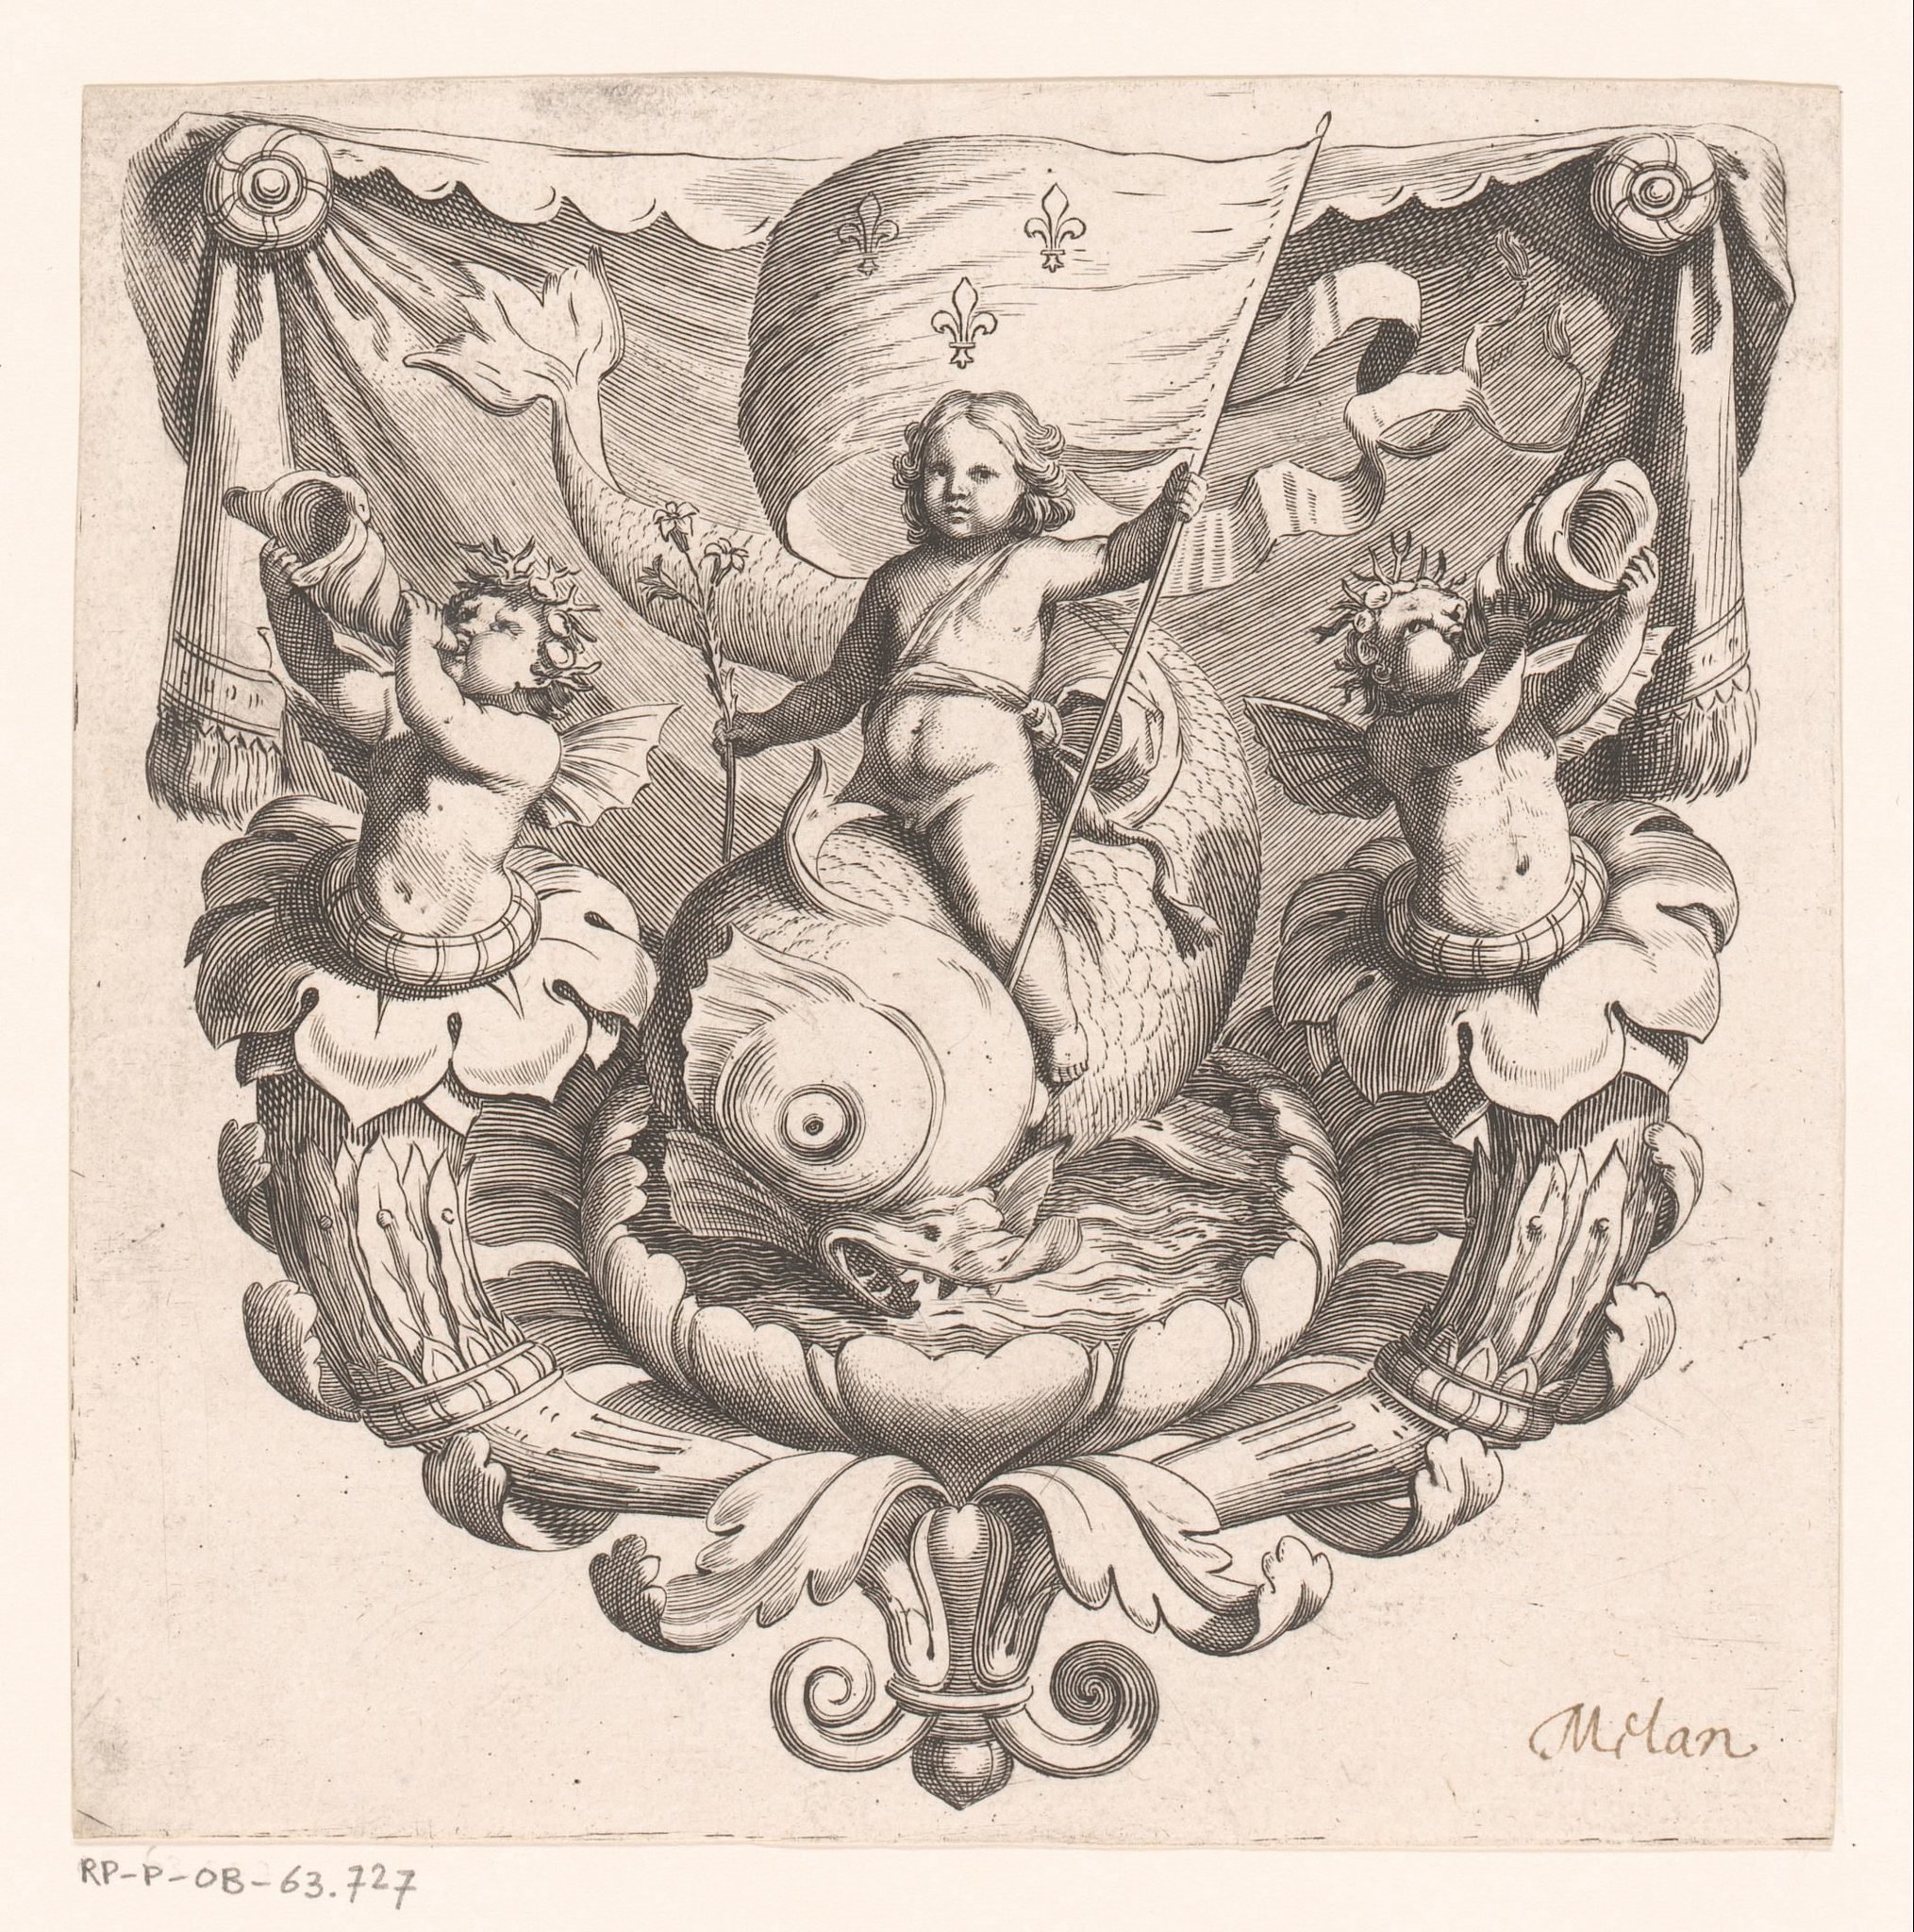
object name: print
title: Allegorische voorstelling met mogelijk de Dauphin gezeten op een dolfijn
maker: pierre daret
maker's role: print maker, publisher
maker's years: 1604-1678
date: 1614-1678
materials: paper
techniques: engraving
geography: france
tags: triton(s), swimming mammals: dolphin, historical persons, crown prince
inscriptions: collector's mark: Lugt 240, inscription: ‘Melan’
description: Een jongen, mogelijk de Dauphin, gezeten op een dolfijn met in zijn rechterhand een lelie en in zijn linkerhand een vlag met drie fleur de lis. Aan weerszijden jonge tritons, blazend op schelpen.